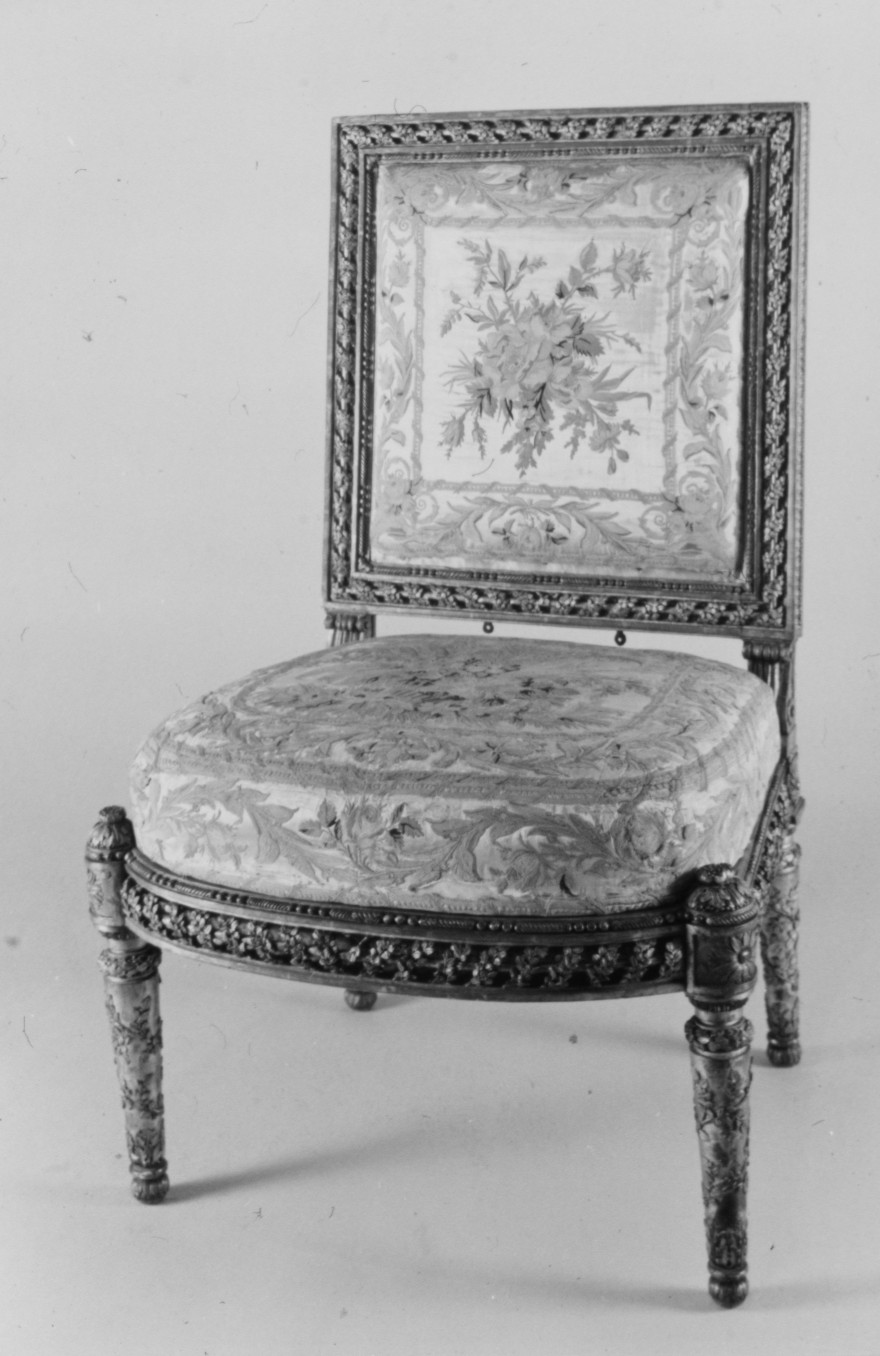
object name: side chair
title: Side chair (one of a pair) (part of a set)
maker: georges jacob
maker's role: maker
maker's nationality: french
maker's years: 1739-1814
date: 1775-1780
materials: silk, wood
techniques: carving, embroidery, gilding